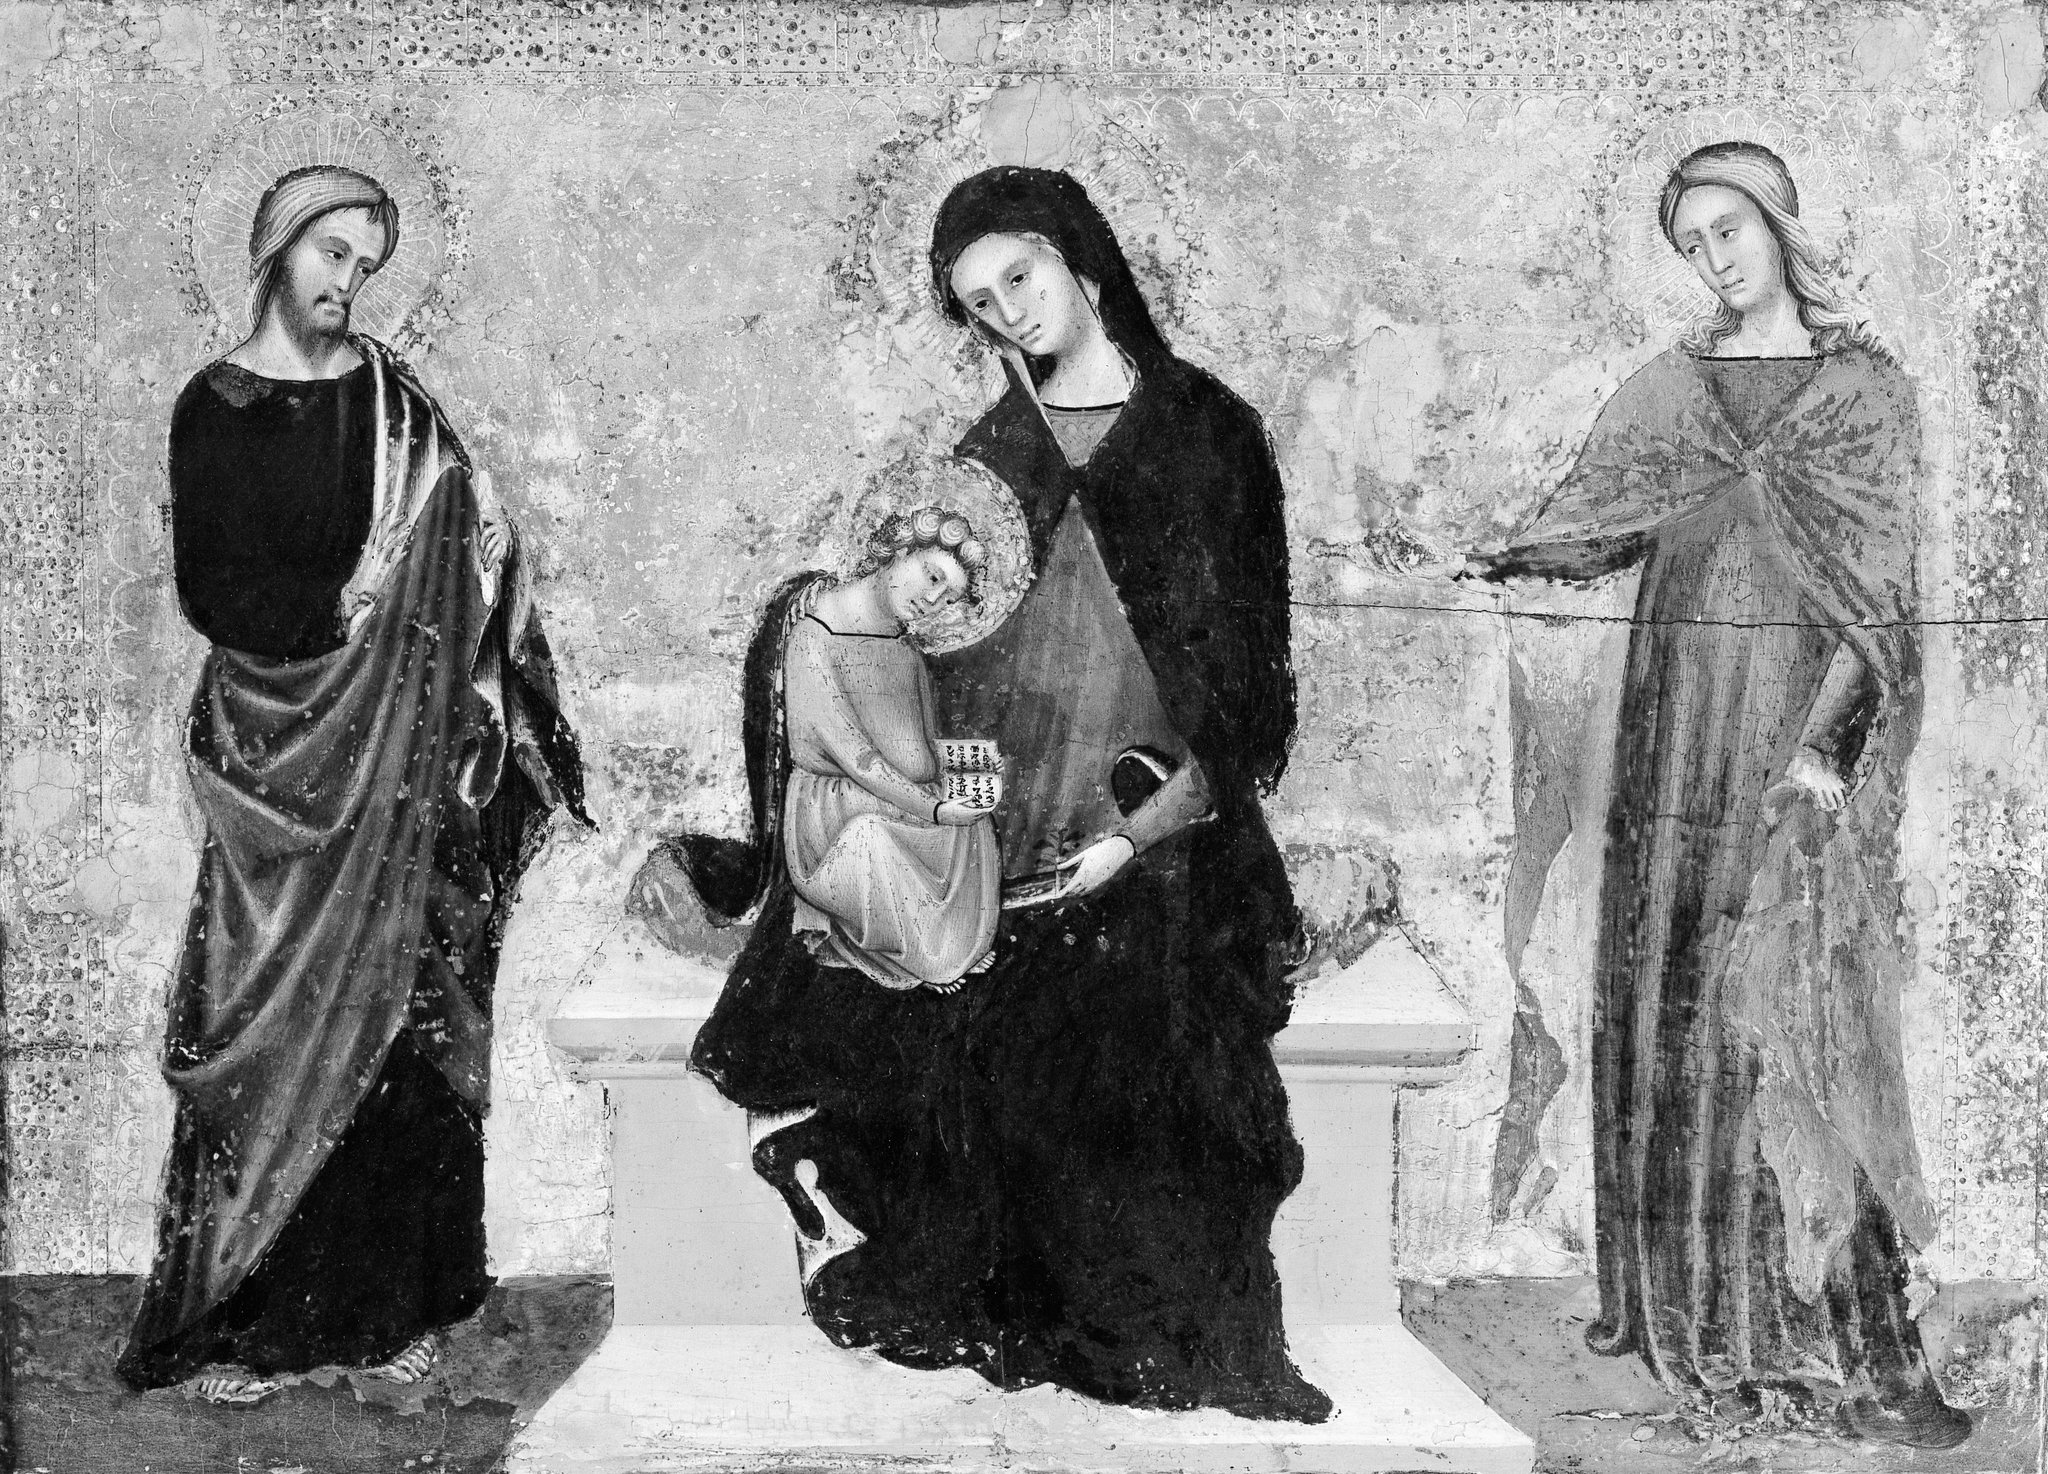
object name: painting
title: Madonna and Child Enthroned with Saints James Minor and Lucy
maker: marco di paolo veneziano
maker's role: artist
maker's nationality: italian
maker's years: 1362-1390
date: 1362-1390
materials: gold leaf, paint, wood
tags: madonna and child,virgin mary,saints